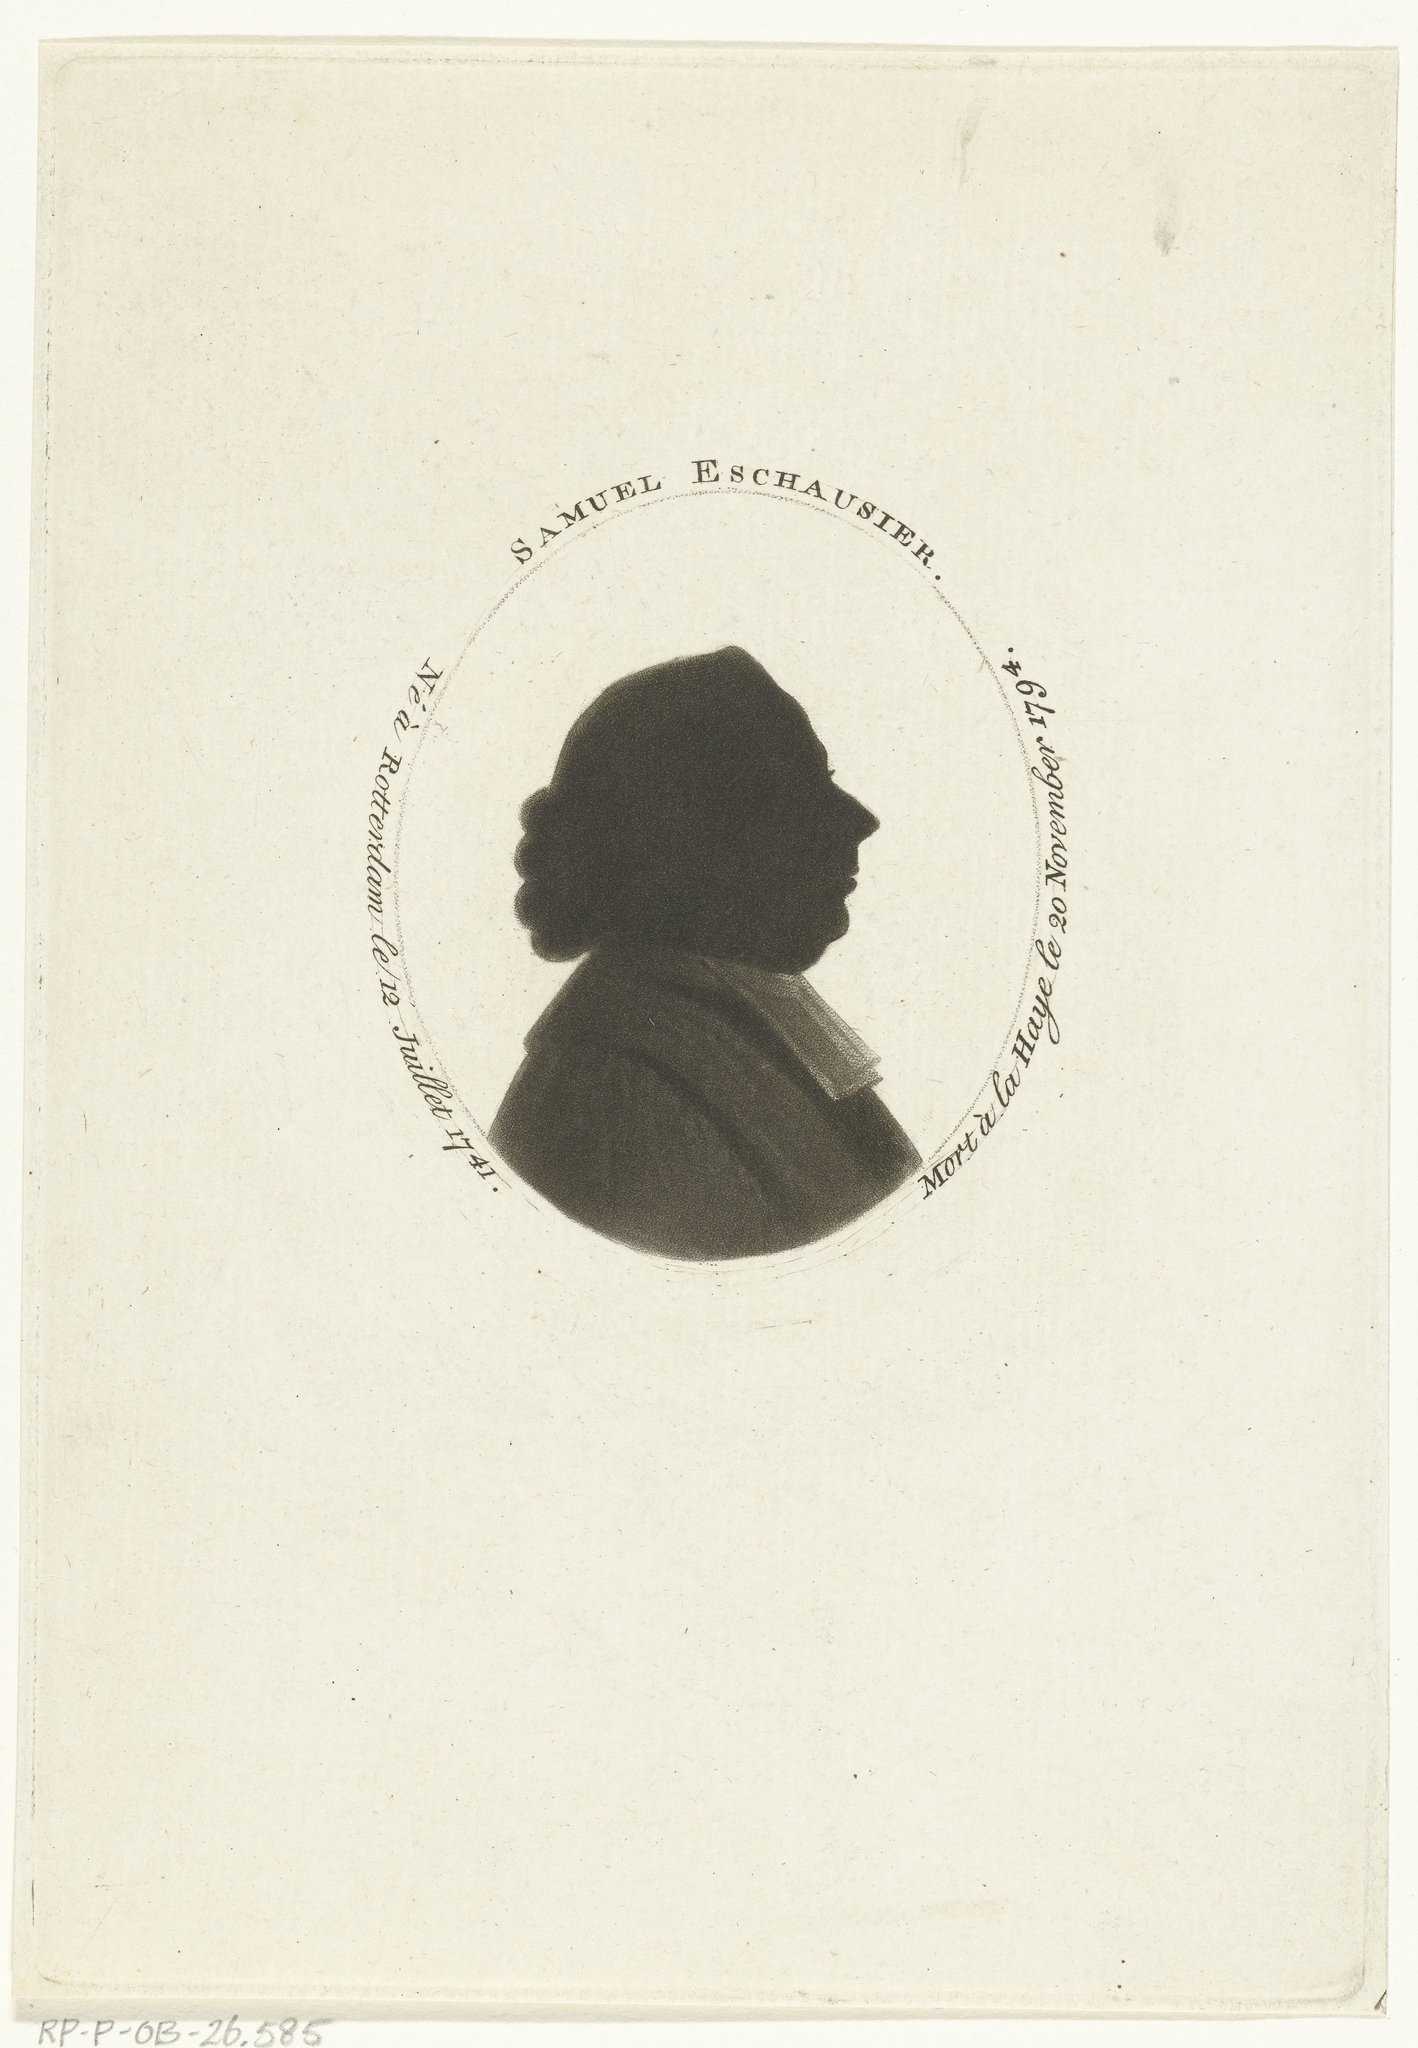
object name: print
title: Silhouetportret van Samuel Eschauzier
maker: johannes christiaan bendorp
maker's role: print maker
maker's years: 1766-1849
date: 1794-1849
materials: paper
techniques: etching, roulette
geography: netherlands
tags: the hague, historical persons, functionaries and dignitaries (with name) ~ episcopal protestant churches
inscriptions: collector's mark: Lugt 2228